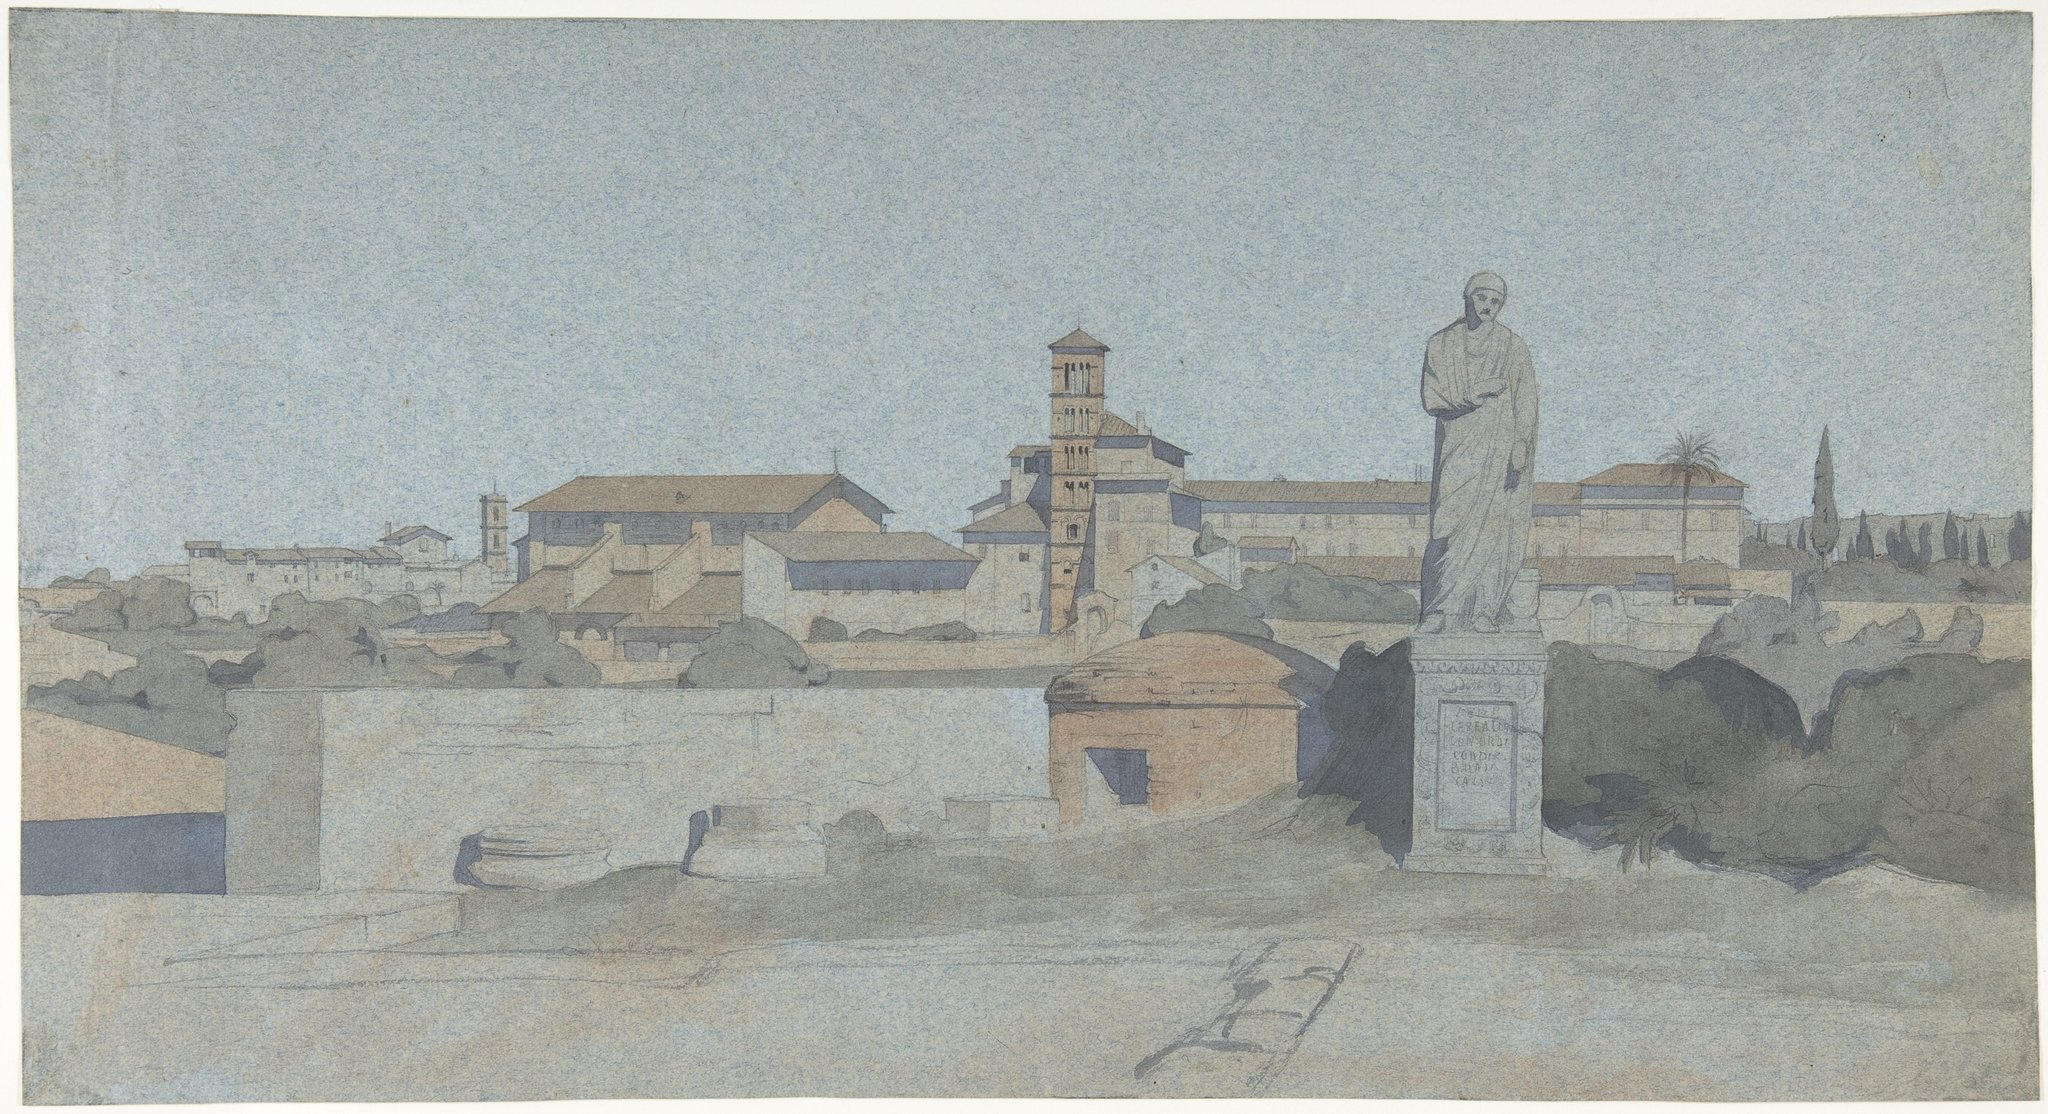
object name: drawing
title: SS. Giovanni e Paolo, seen from the Villa Mattei, Rome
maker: jean-achille benouville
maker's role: artist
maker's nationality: french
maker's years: 1815-1891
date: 1825-1891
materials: graphite, paper, watercolor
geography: france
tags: sculpture,buildings,towers,rome